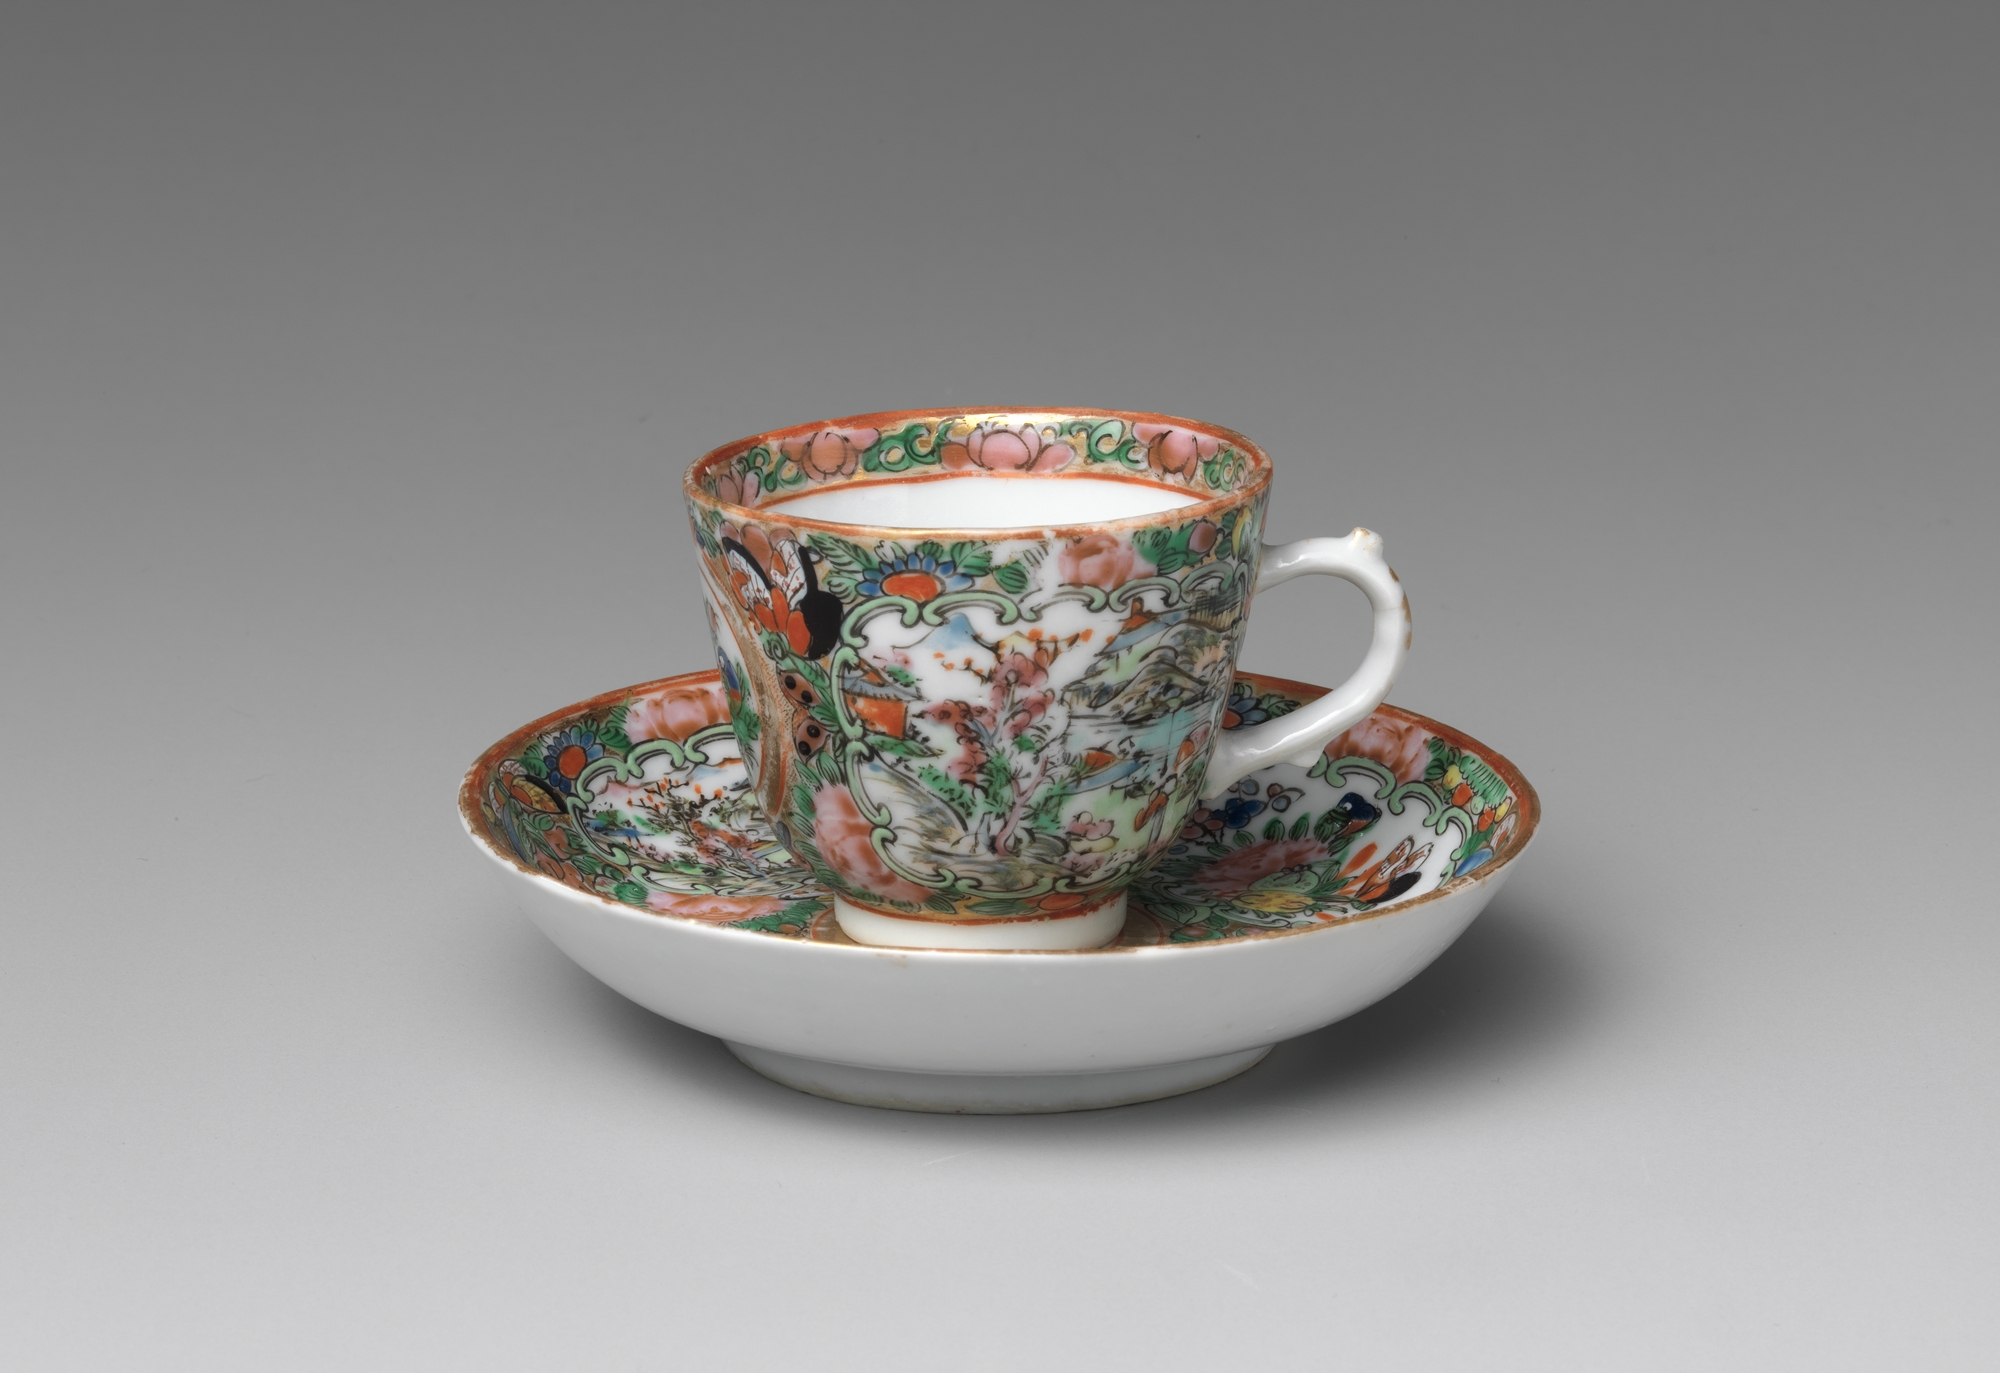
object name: demitasse cup and saucer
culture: chinese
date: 1860-1866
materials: porcelain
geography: china